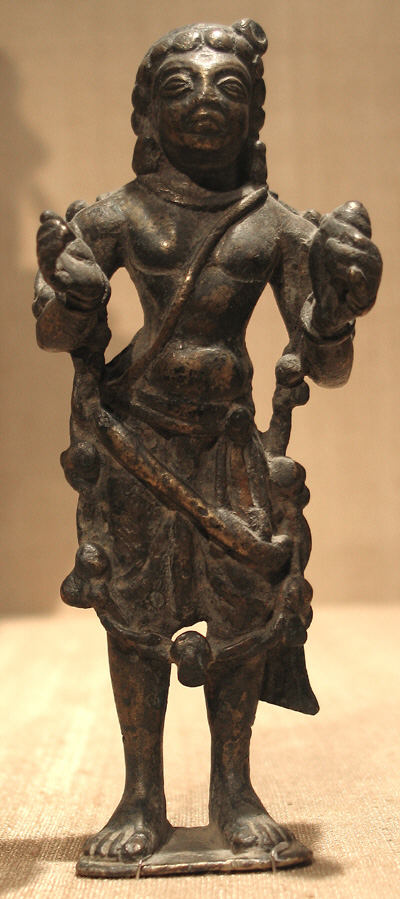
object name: figure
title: Standing Male Deity (Perhaps Vishnu) Holding a Conch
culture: afghan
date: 501-600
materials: bronze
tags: gandharan,vishnu